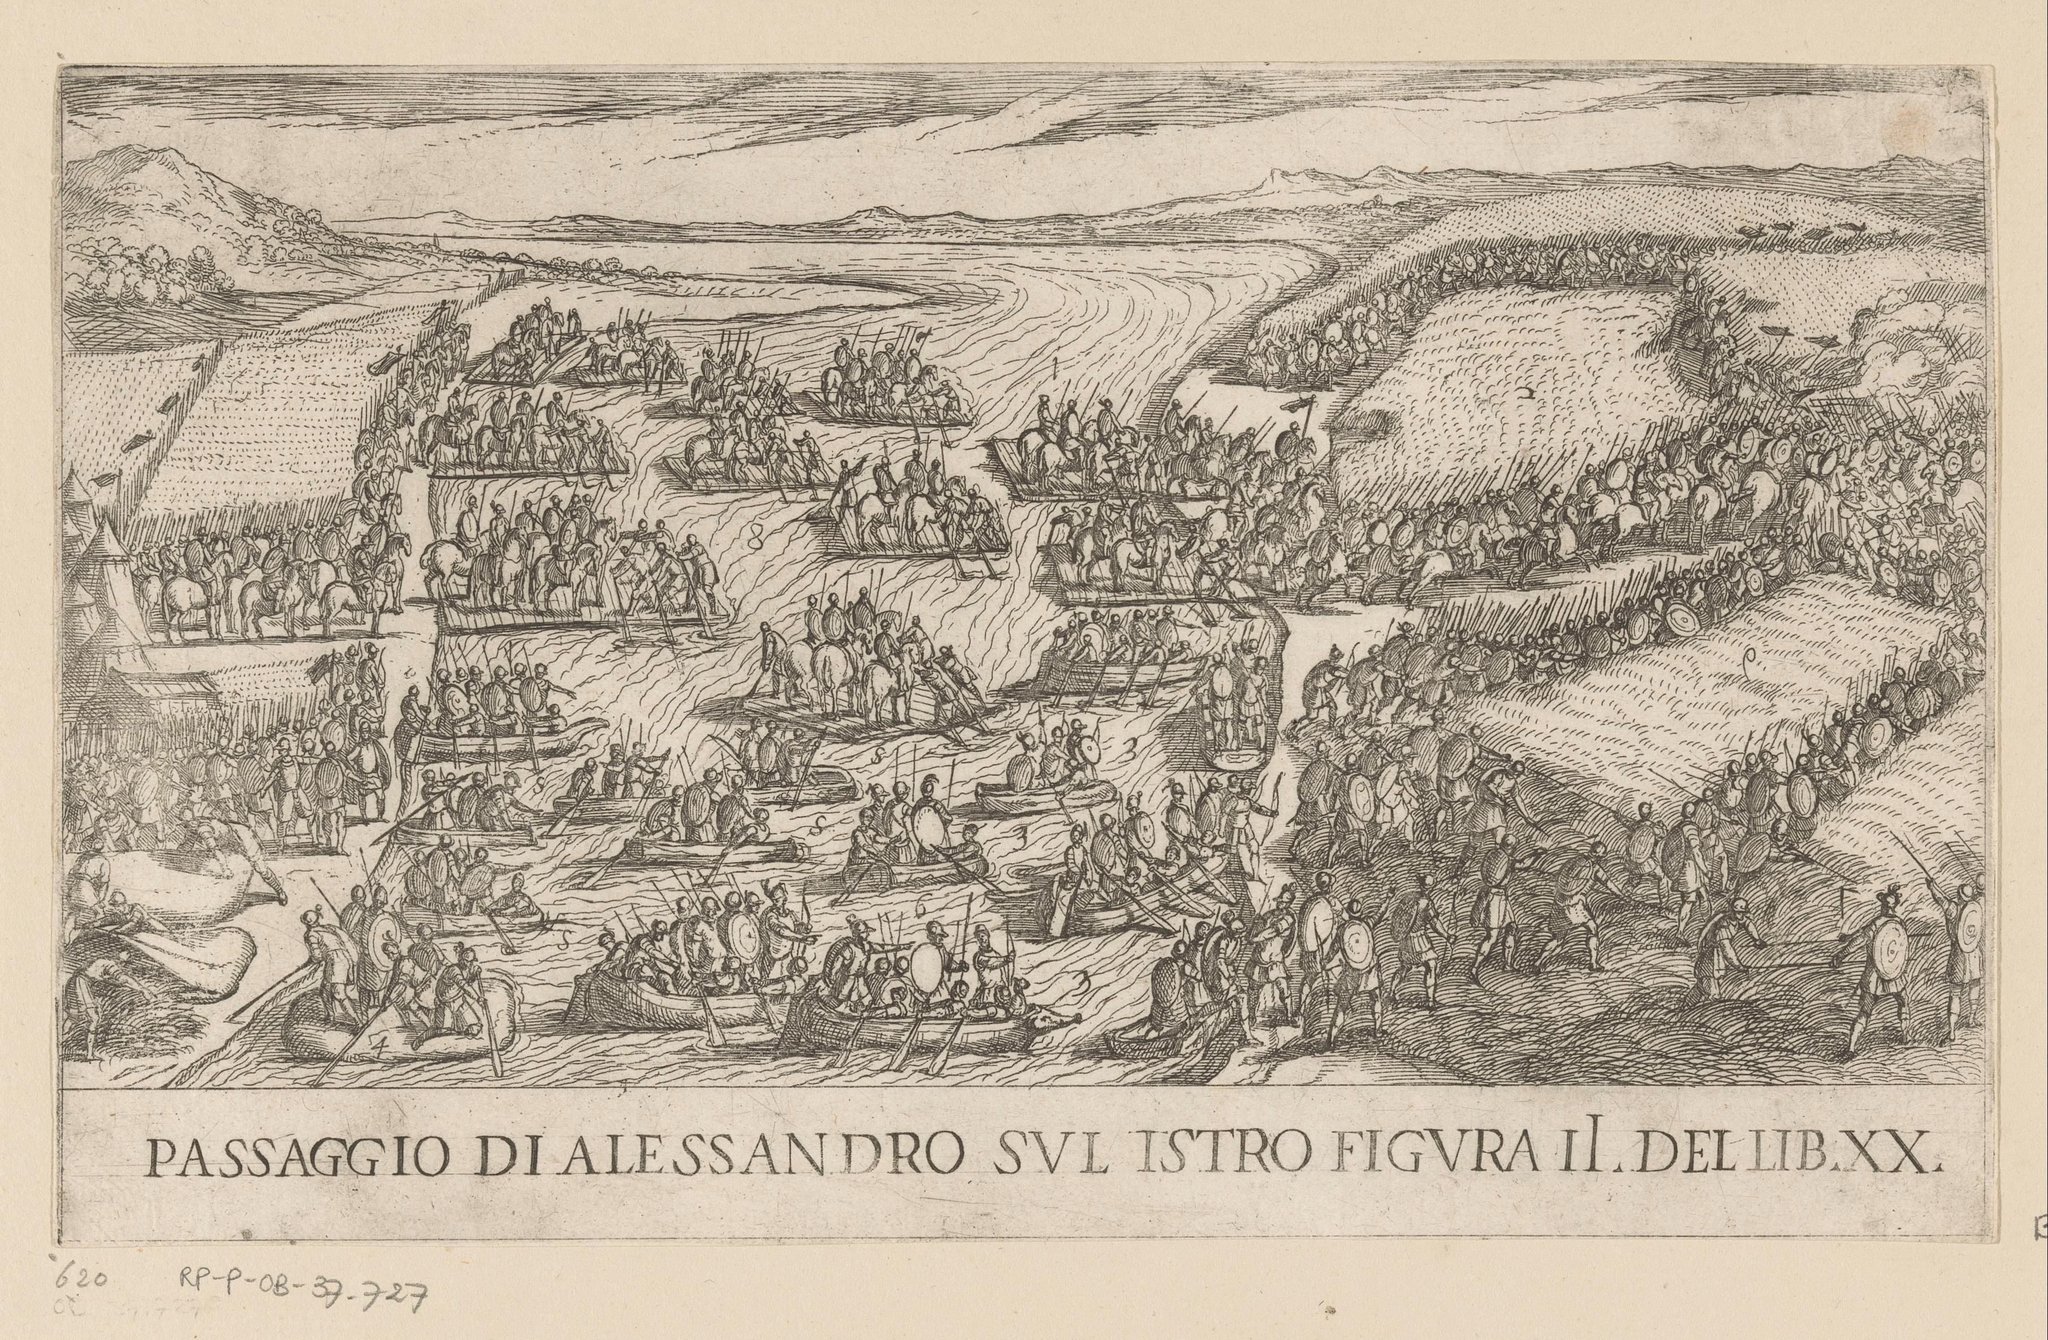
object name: print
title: Alexander de Grote steekt de rivier de Ister over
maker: antonio tempesta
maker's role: draughtsman, painter, print maker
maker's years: 1555-1630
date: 1565-1630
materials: paper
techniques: etching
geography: italy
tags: crossing a river, (story of) alexander the great, the soldier; the soldier's life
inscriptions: collector's mark: Lugt 240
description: Deze prent maakt deel uit van een reeks van 9 prenten, die ook gebruikt werden als illustraties voor Francesco Patrizi's Paralleli militaro, ne'quali si fa paragone delle Milizie antiche, in tutte le parti loro, con lemoderne, Luigi Zanetti: Rome, 1594.